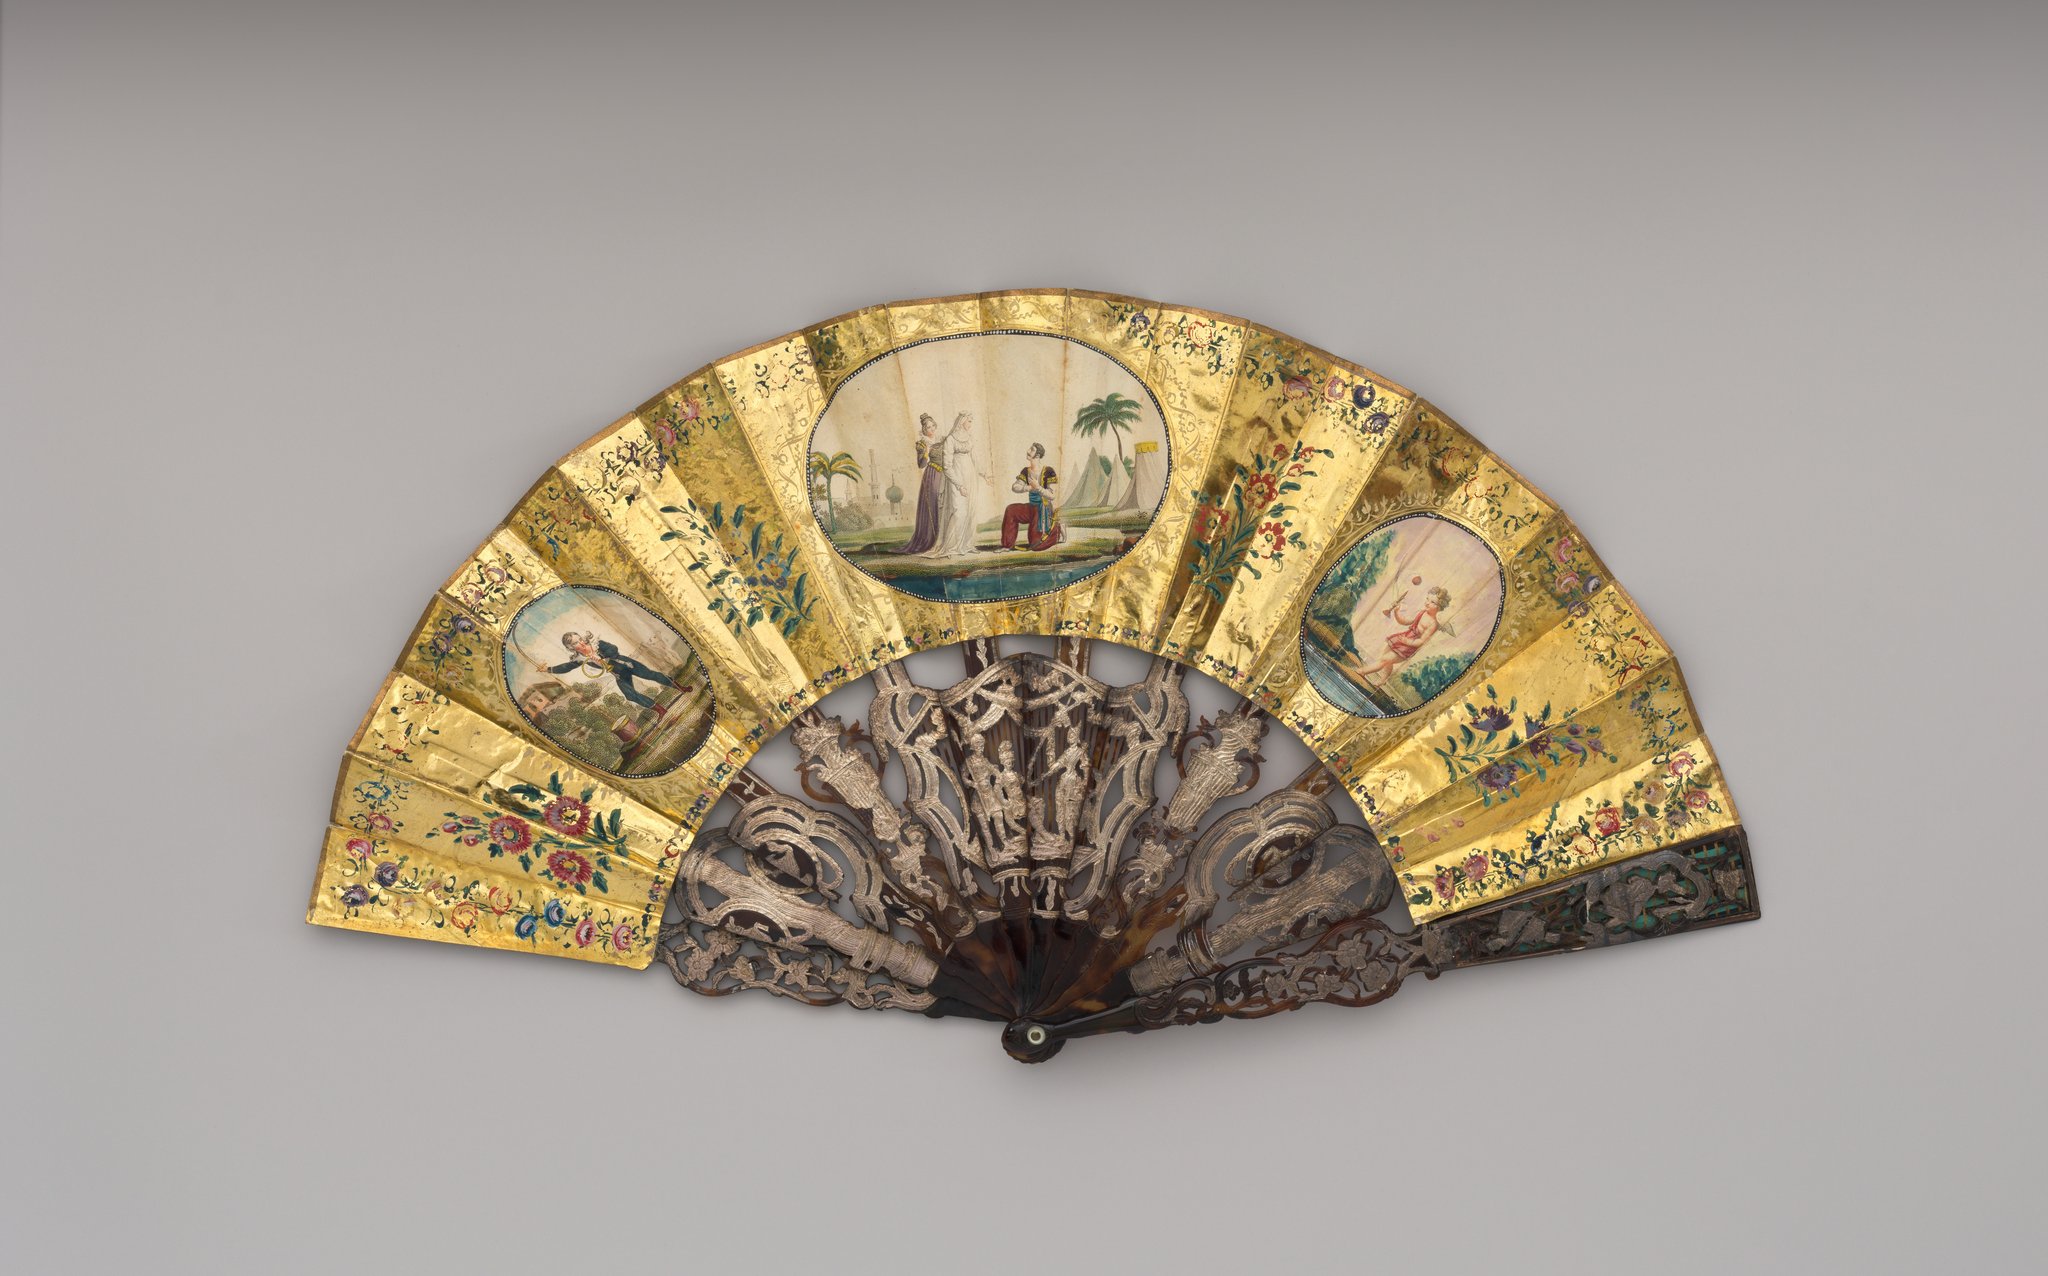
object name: fan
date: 1801-1833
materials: gilt, paint, paper, shell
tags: men,women